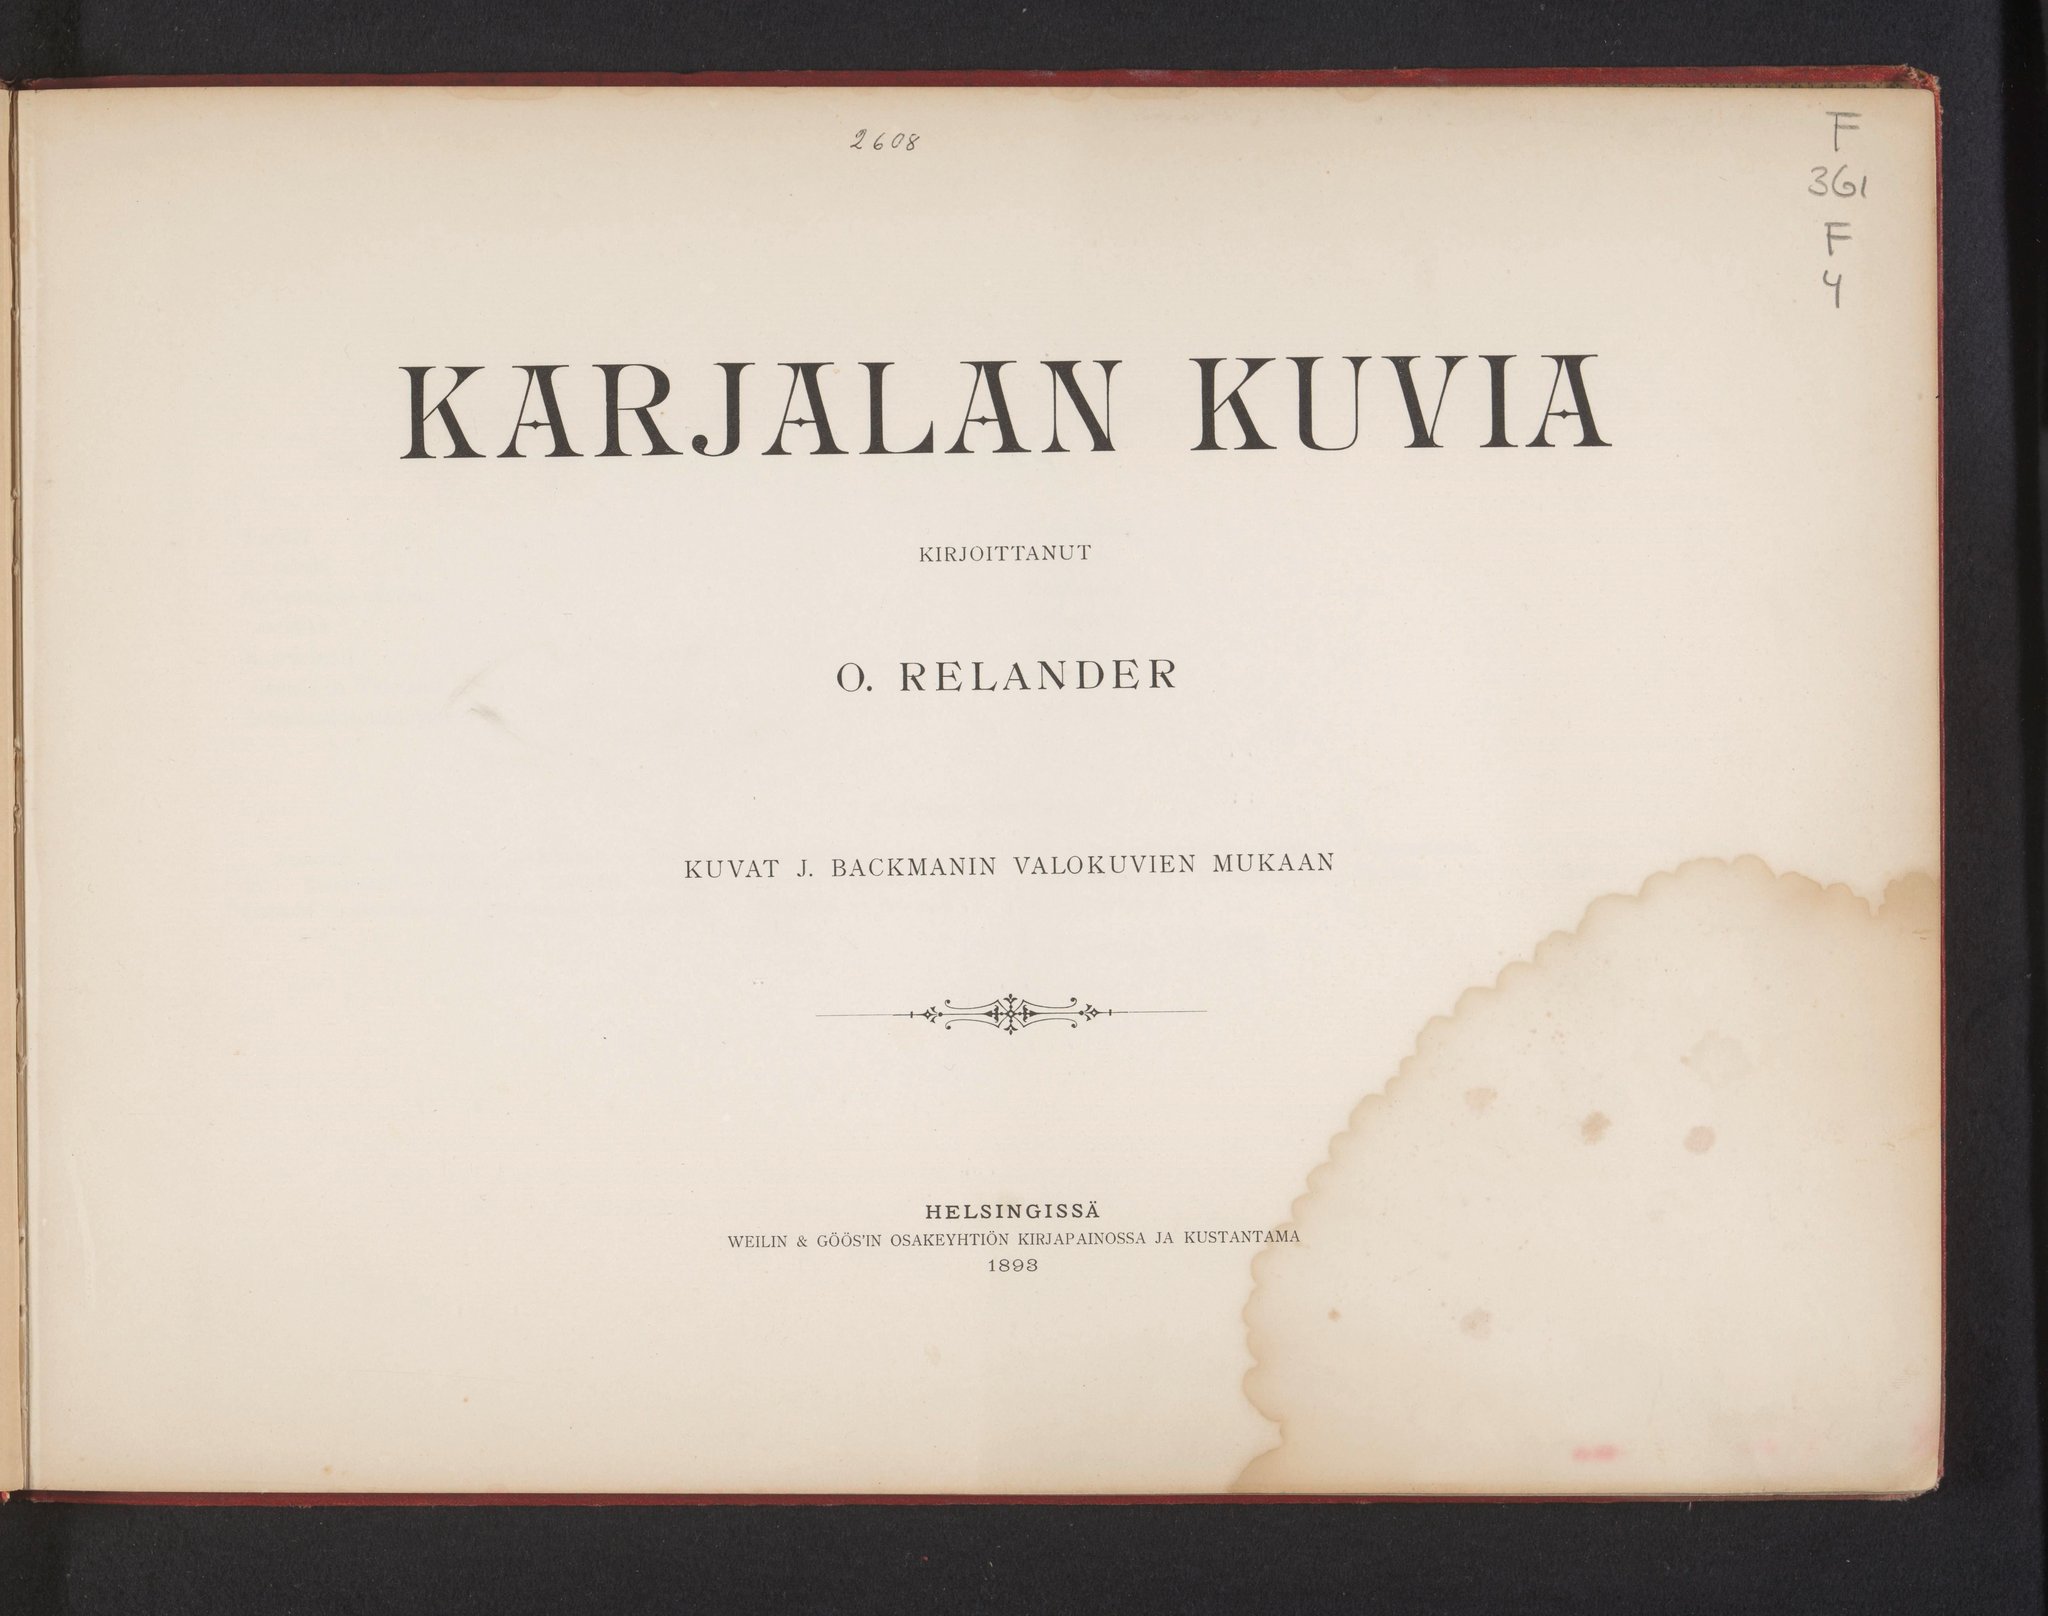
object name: book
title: Karjalan kuvia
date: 1893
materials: cardboard, paper, textile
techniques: printing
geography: helsinki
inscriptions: inscription: ‘SEPT/ 1995’